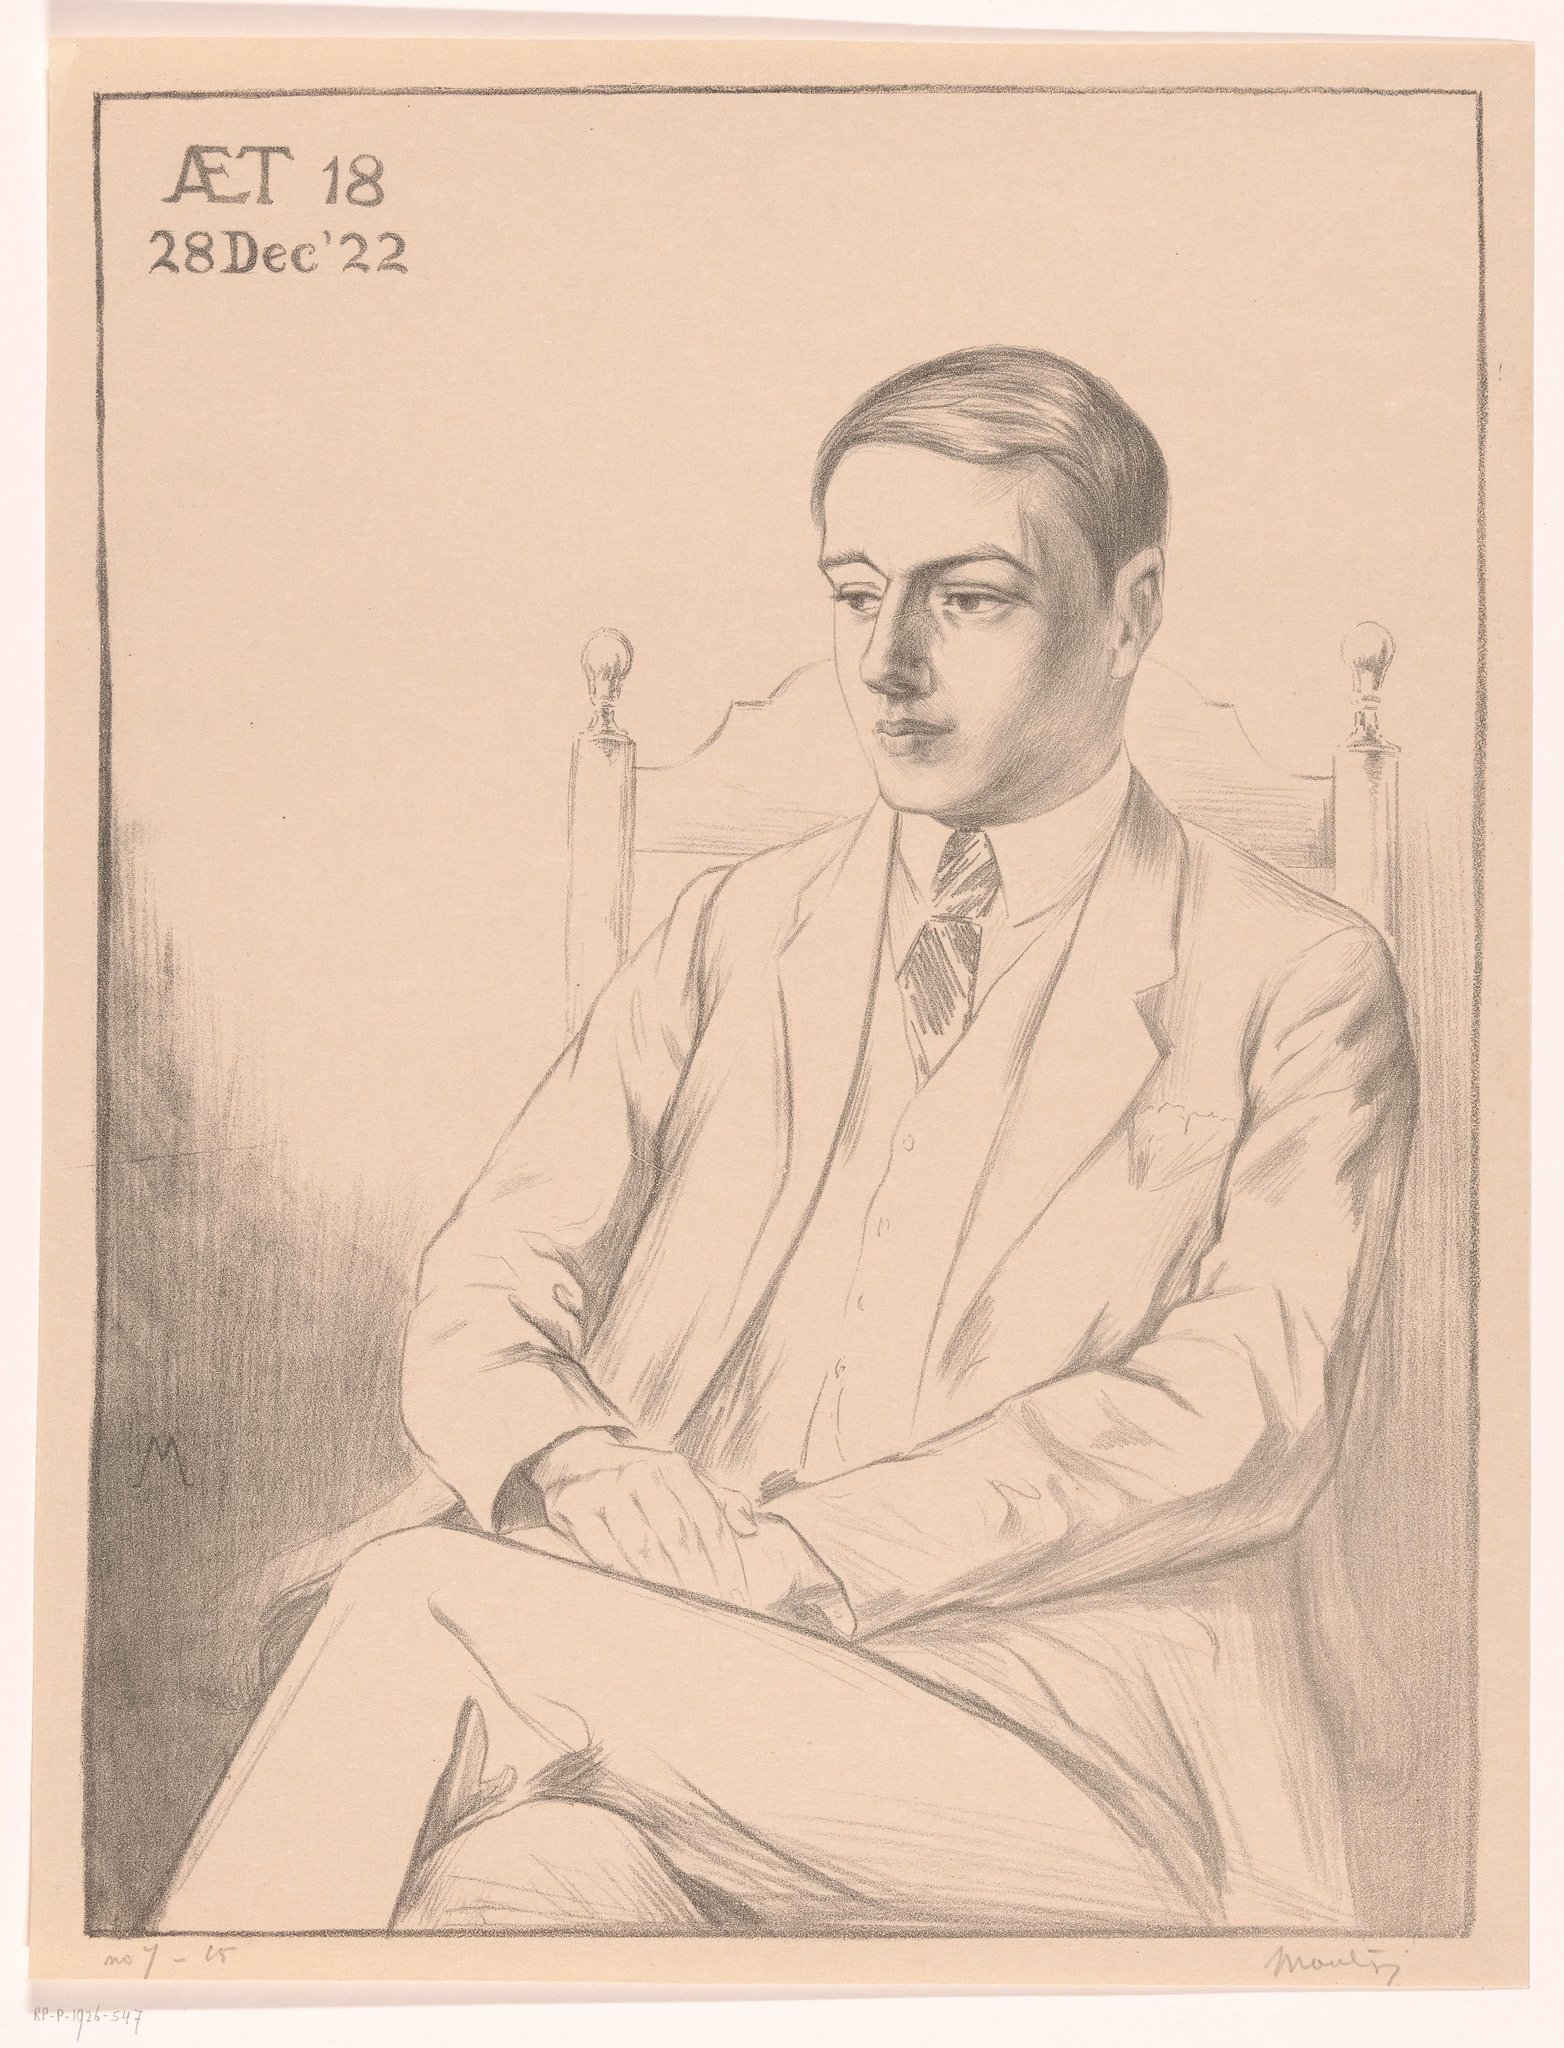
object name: print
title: Portret van Eco Moulijn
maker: simon moulijn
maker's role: draughtsman, print maker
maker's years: 1866-1948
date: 1922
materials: paper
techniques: lithograph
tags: historical persons, youth, adolescent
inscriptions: collector's mark: Lugt 2228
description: Eco Moulijn zit in een stoel. Linksboven de tekst: 'AET 18'.